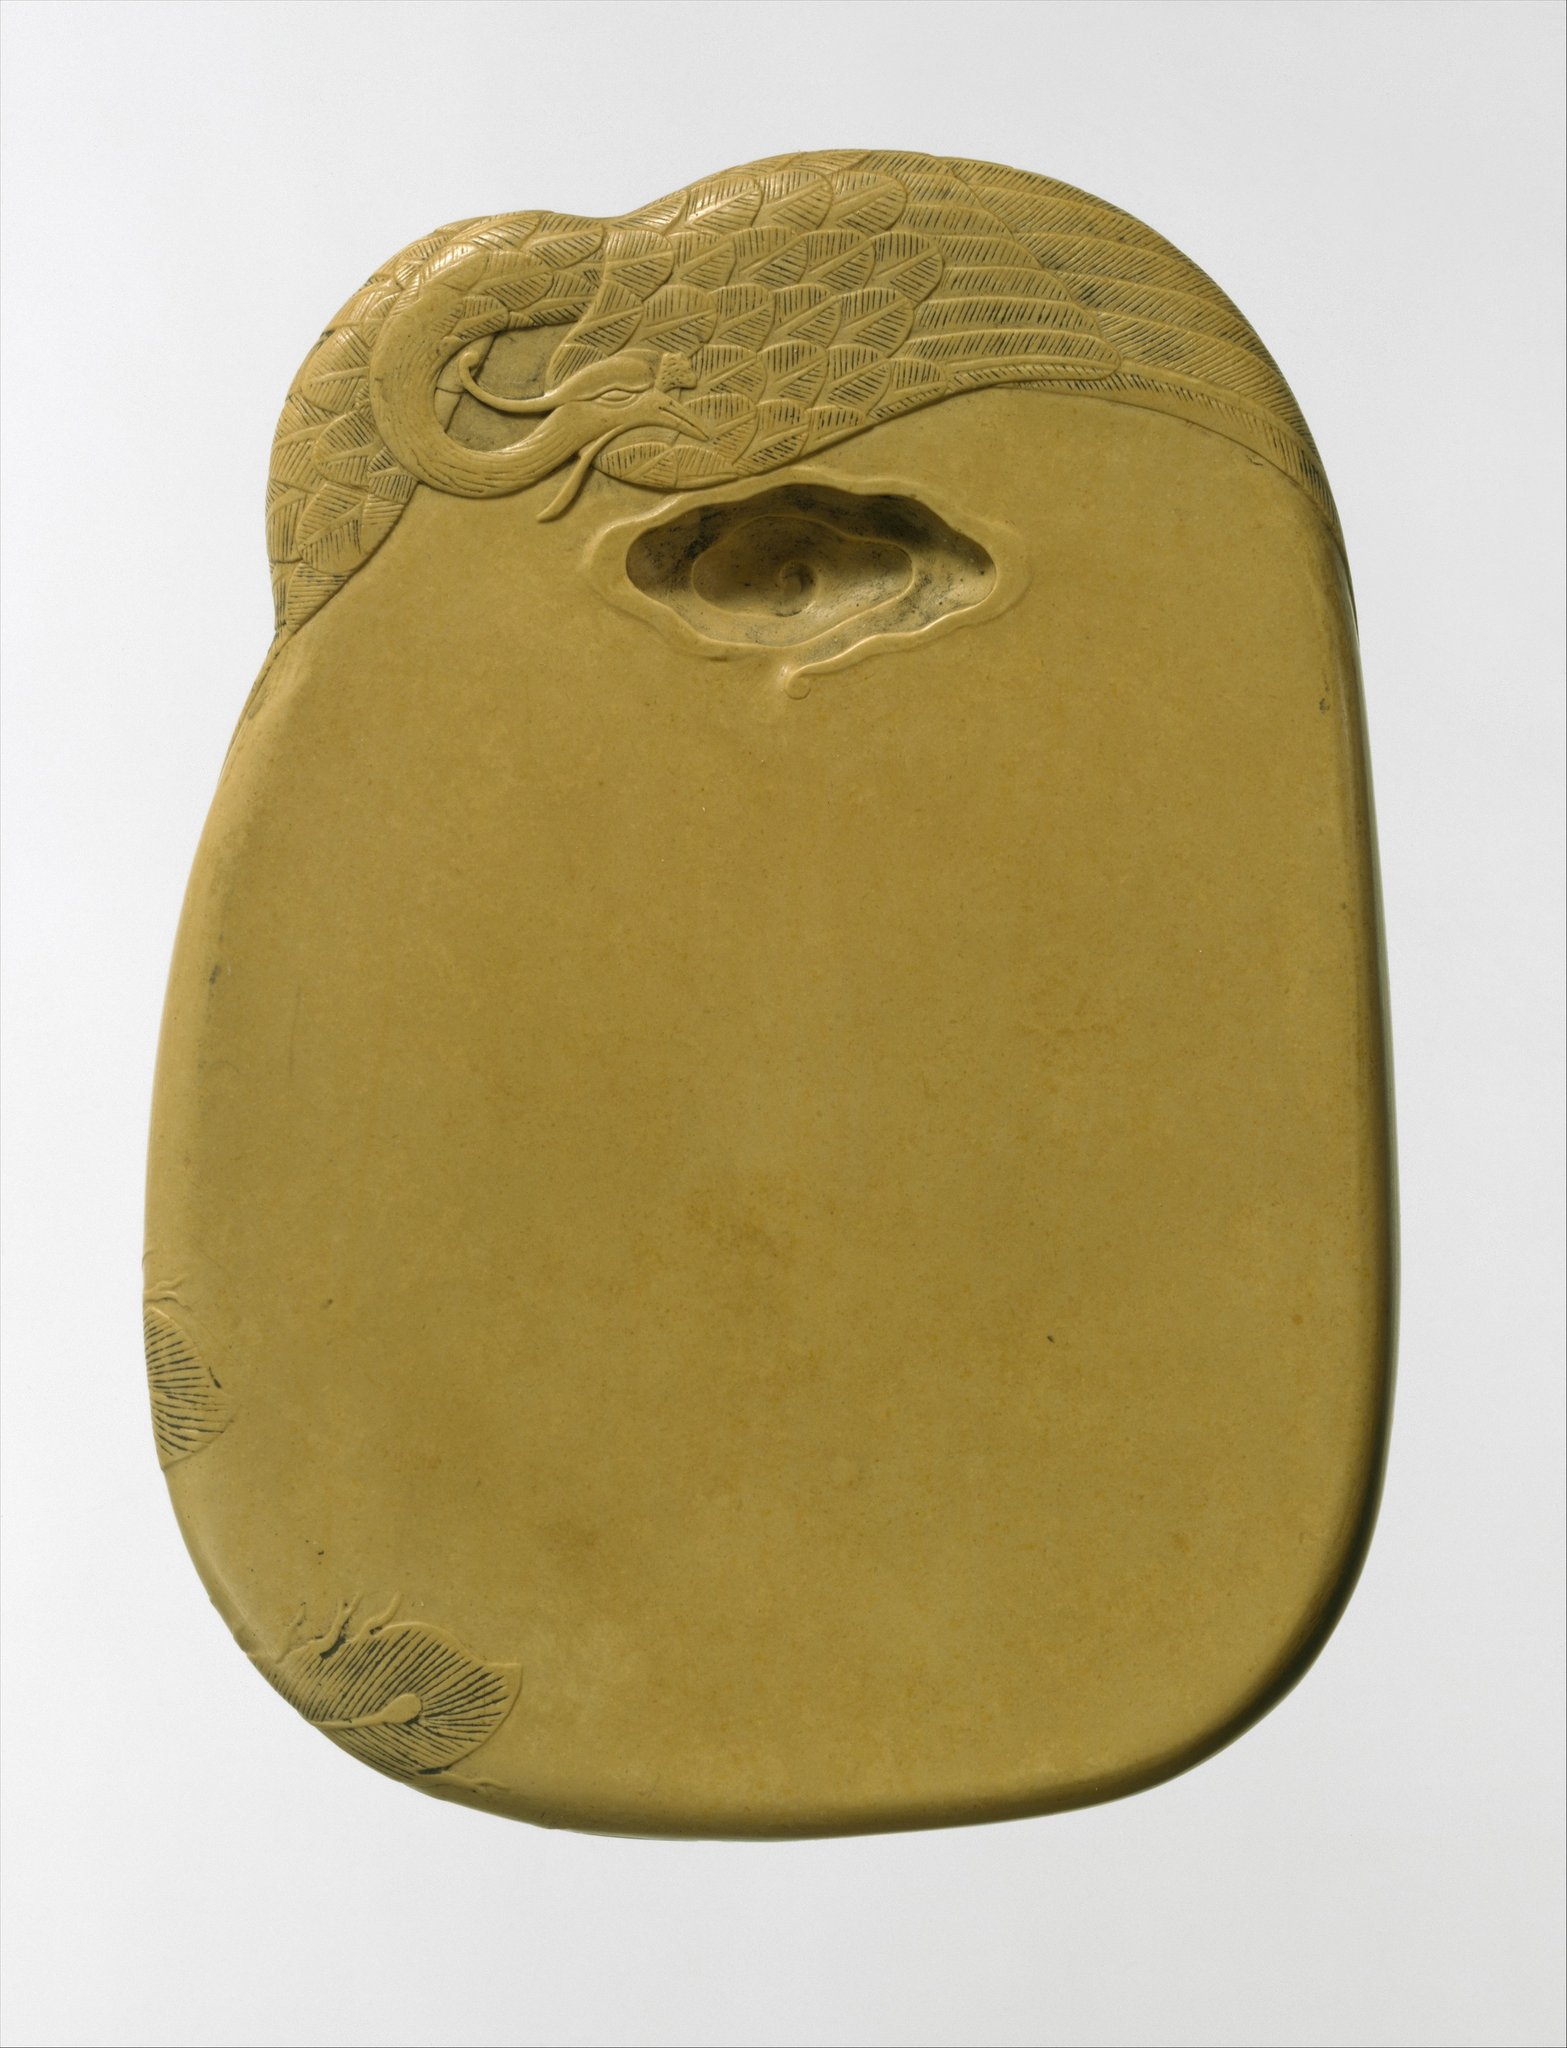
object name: inkstone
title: Inkstone with phoenix design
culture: chinese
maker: gu erniang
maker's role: artist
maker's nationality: chinese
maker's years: 1700-1733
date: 1701-1800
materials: limestone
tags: phoenix